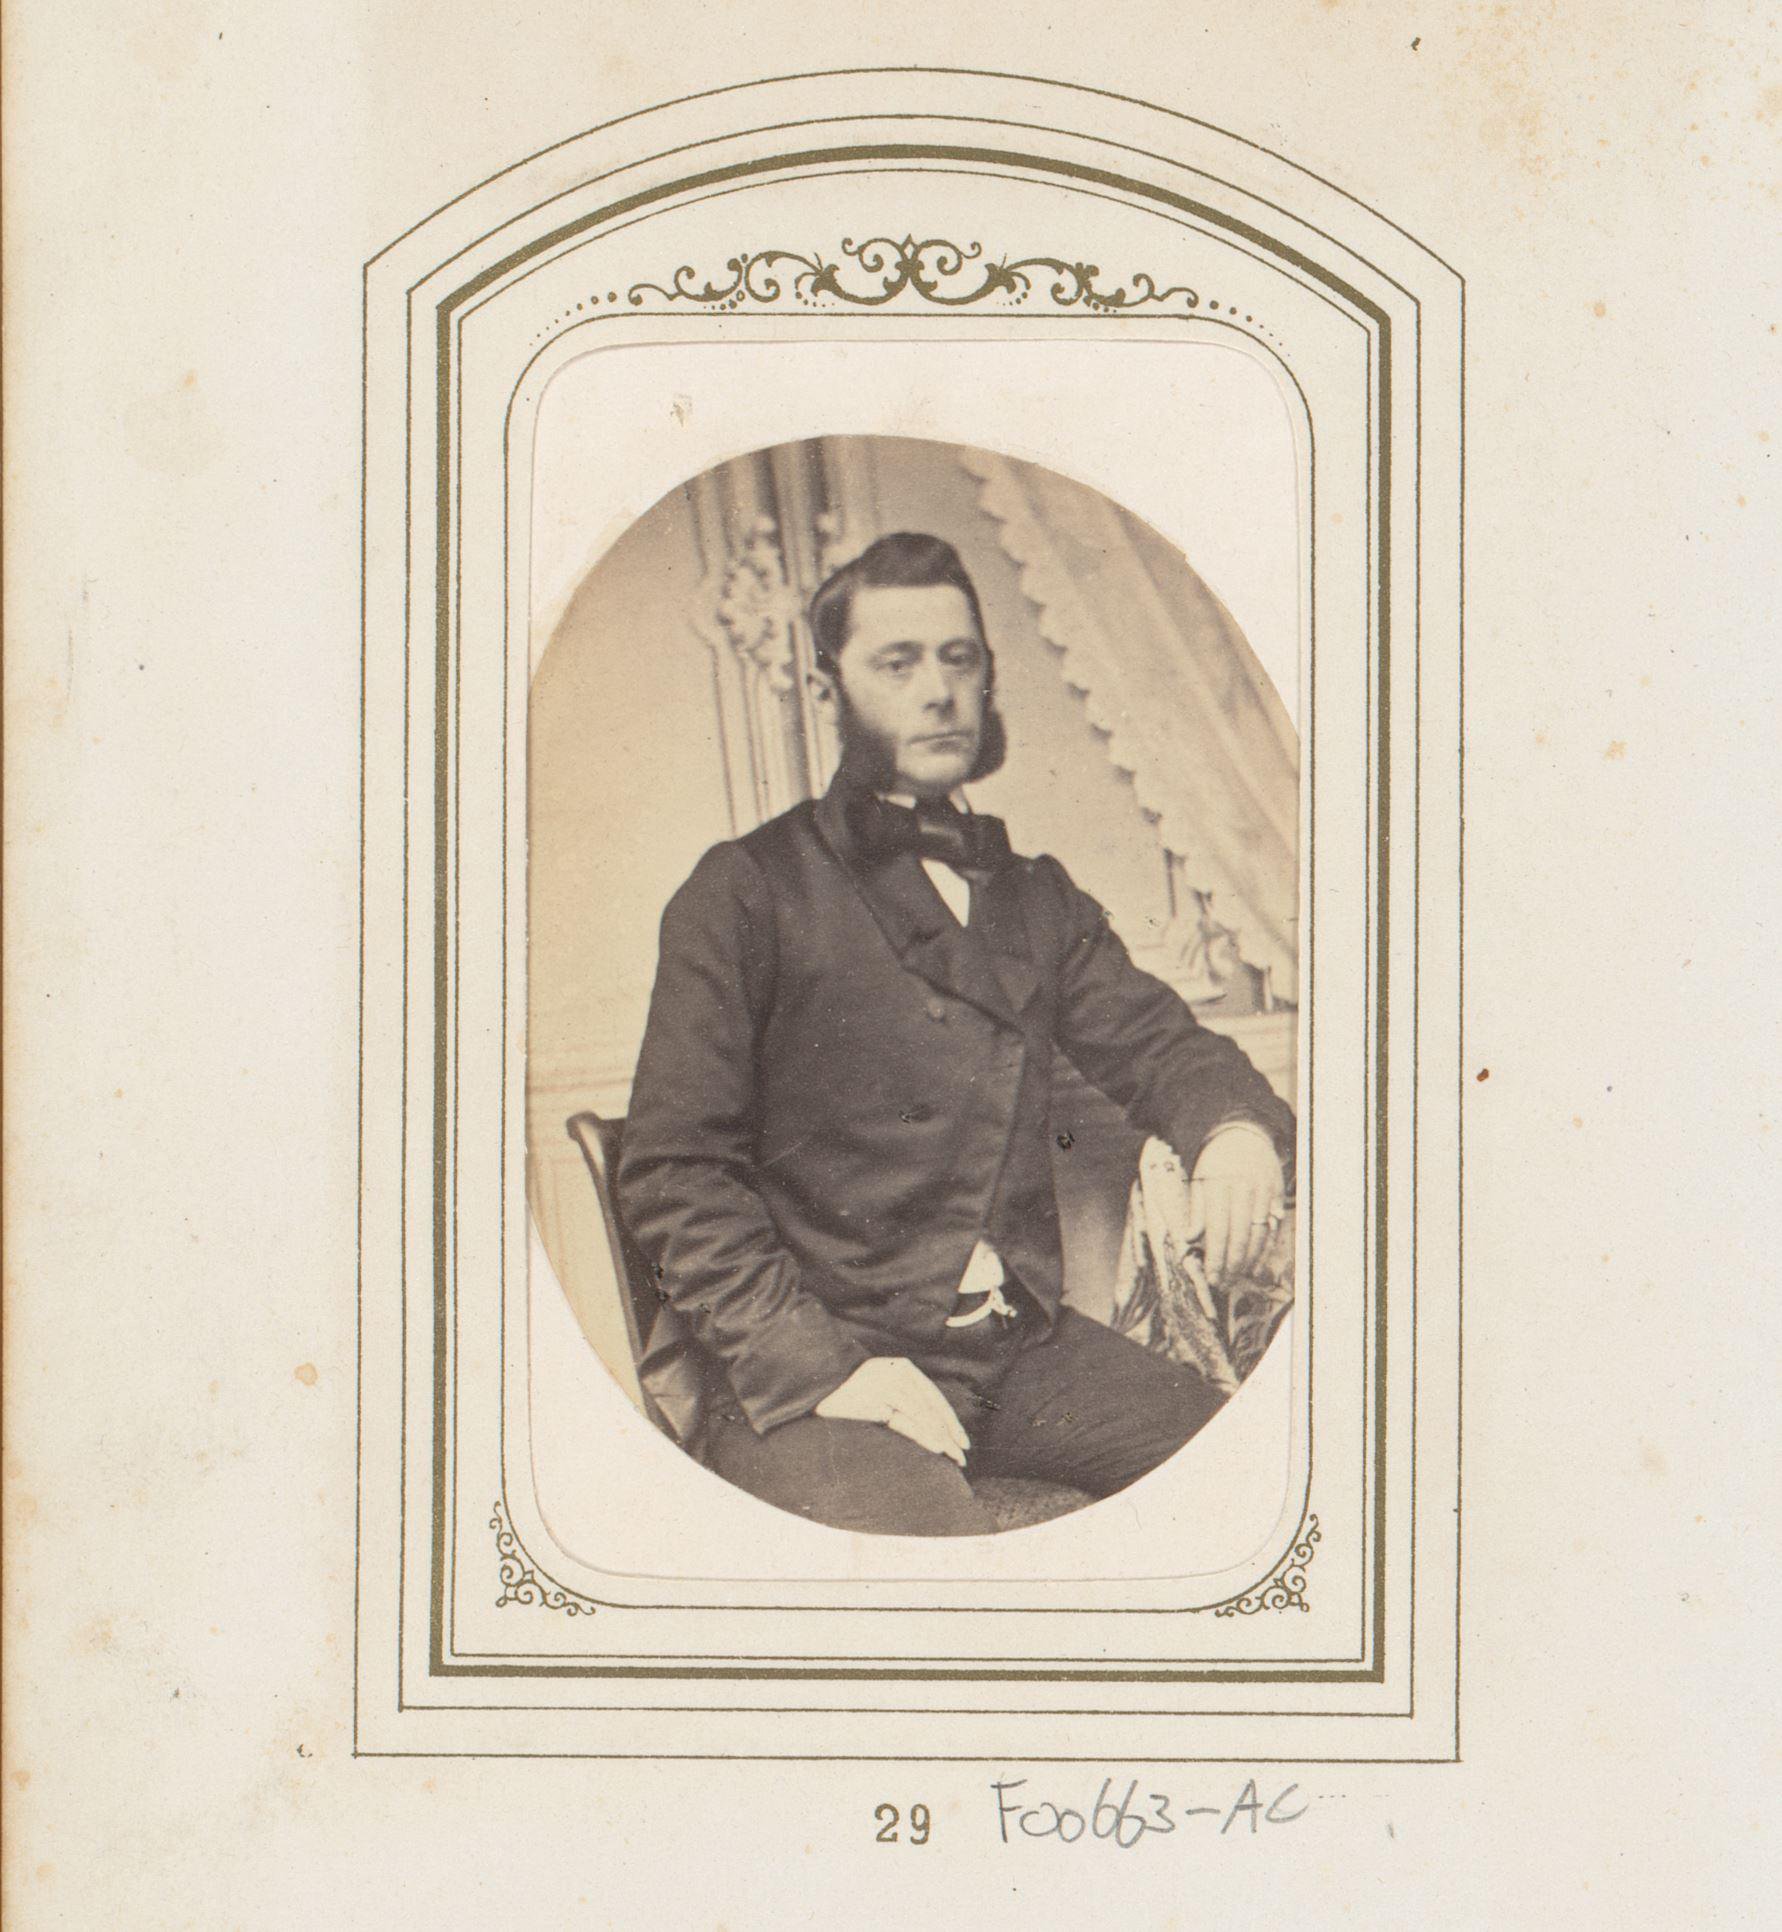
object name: album leaf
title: Portret van een zittende man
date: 1857-1864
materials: cardboard, photographic support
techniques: albumen print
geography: amsterdam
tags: historical persons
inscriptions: number: ‘29’, inscription: ‘Photogr Atelier/ Wegner & Mottu/ Prinsengracht BB.439/ Amsterdam’